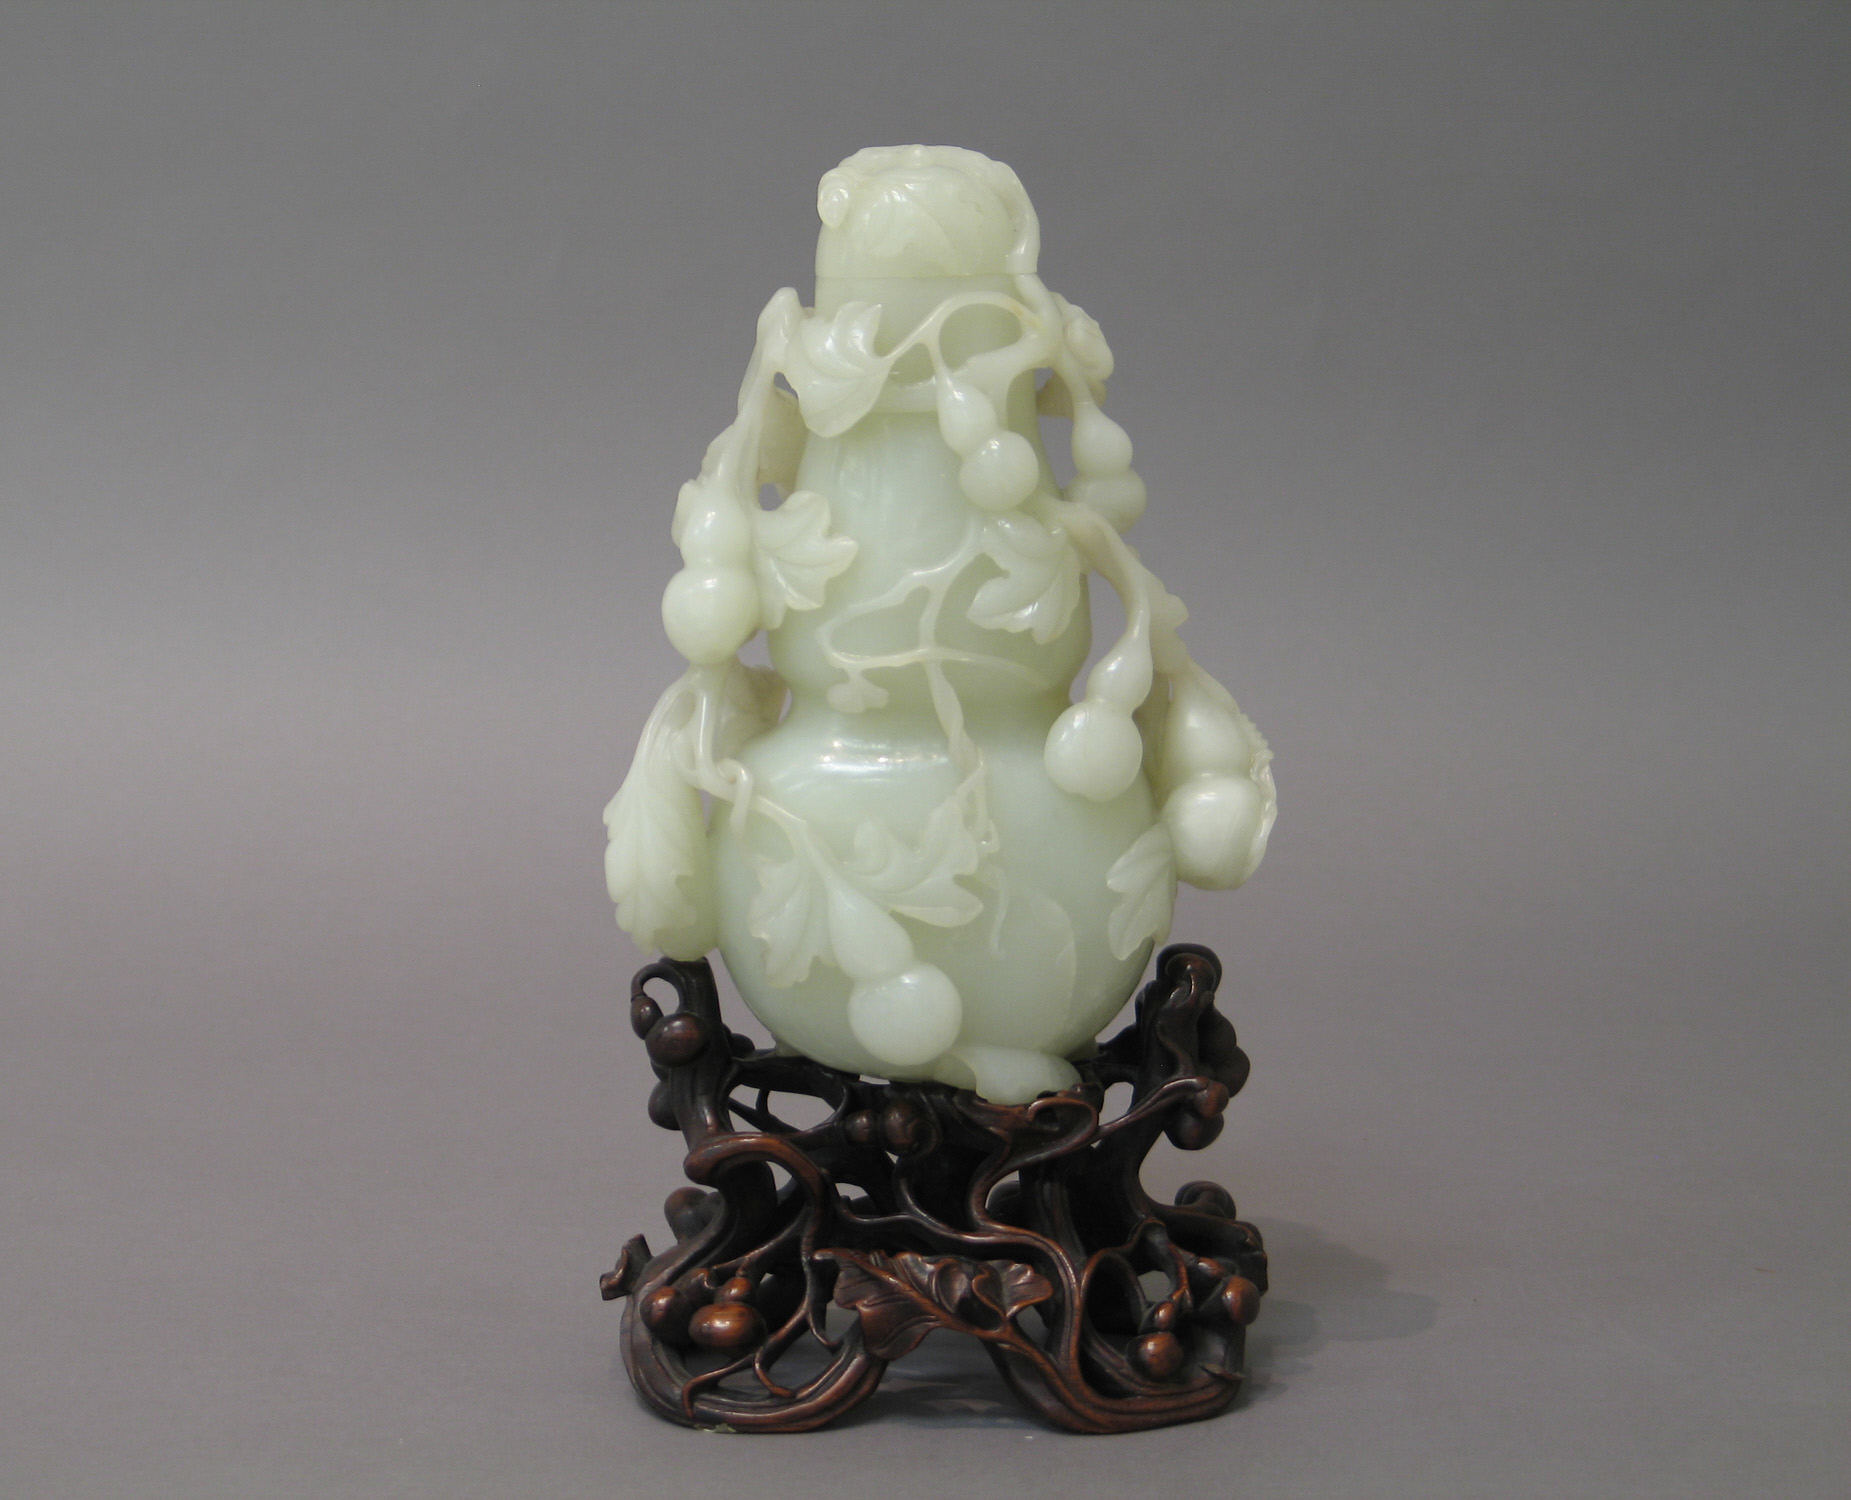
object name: bottle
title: Bottle in the shape of a gourd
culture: chinese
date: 1801-1900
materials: jade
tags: fruit,leaves